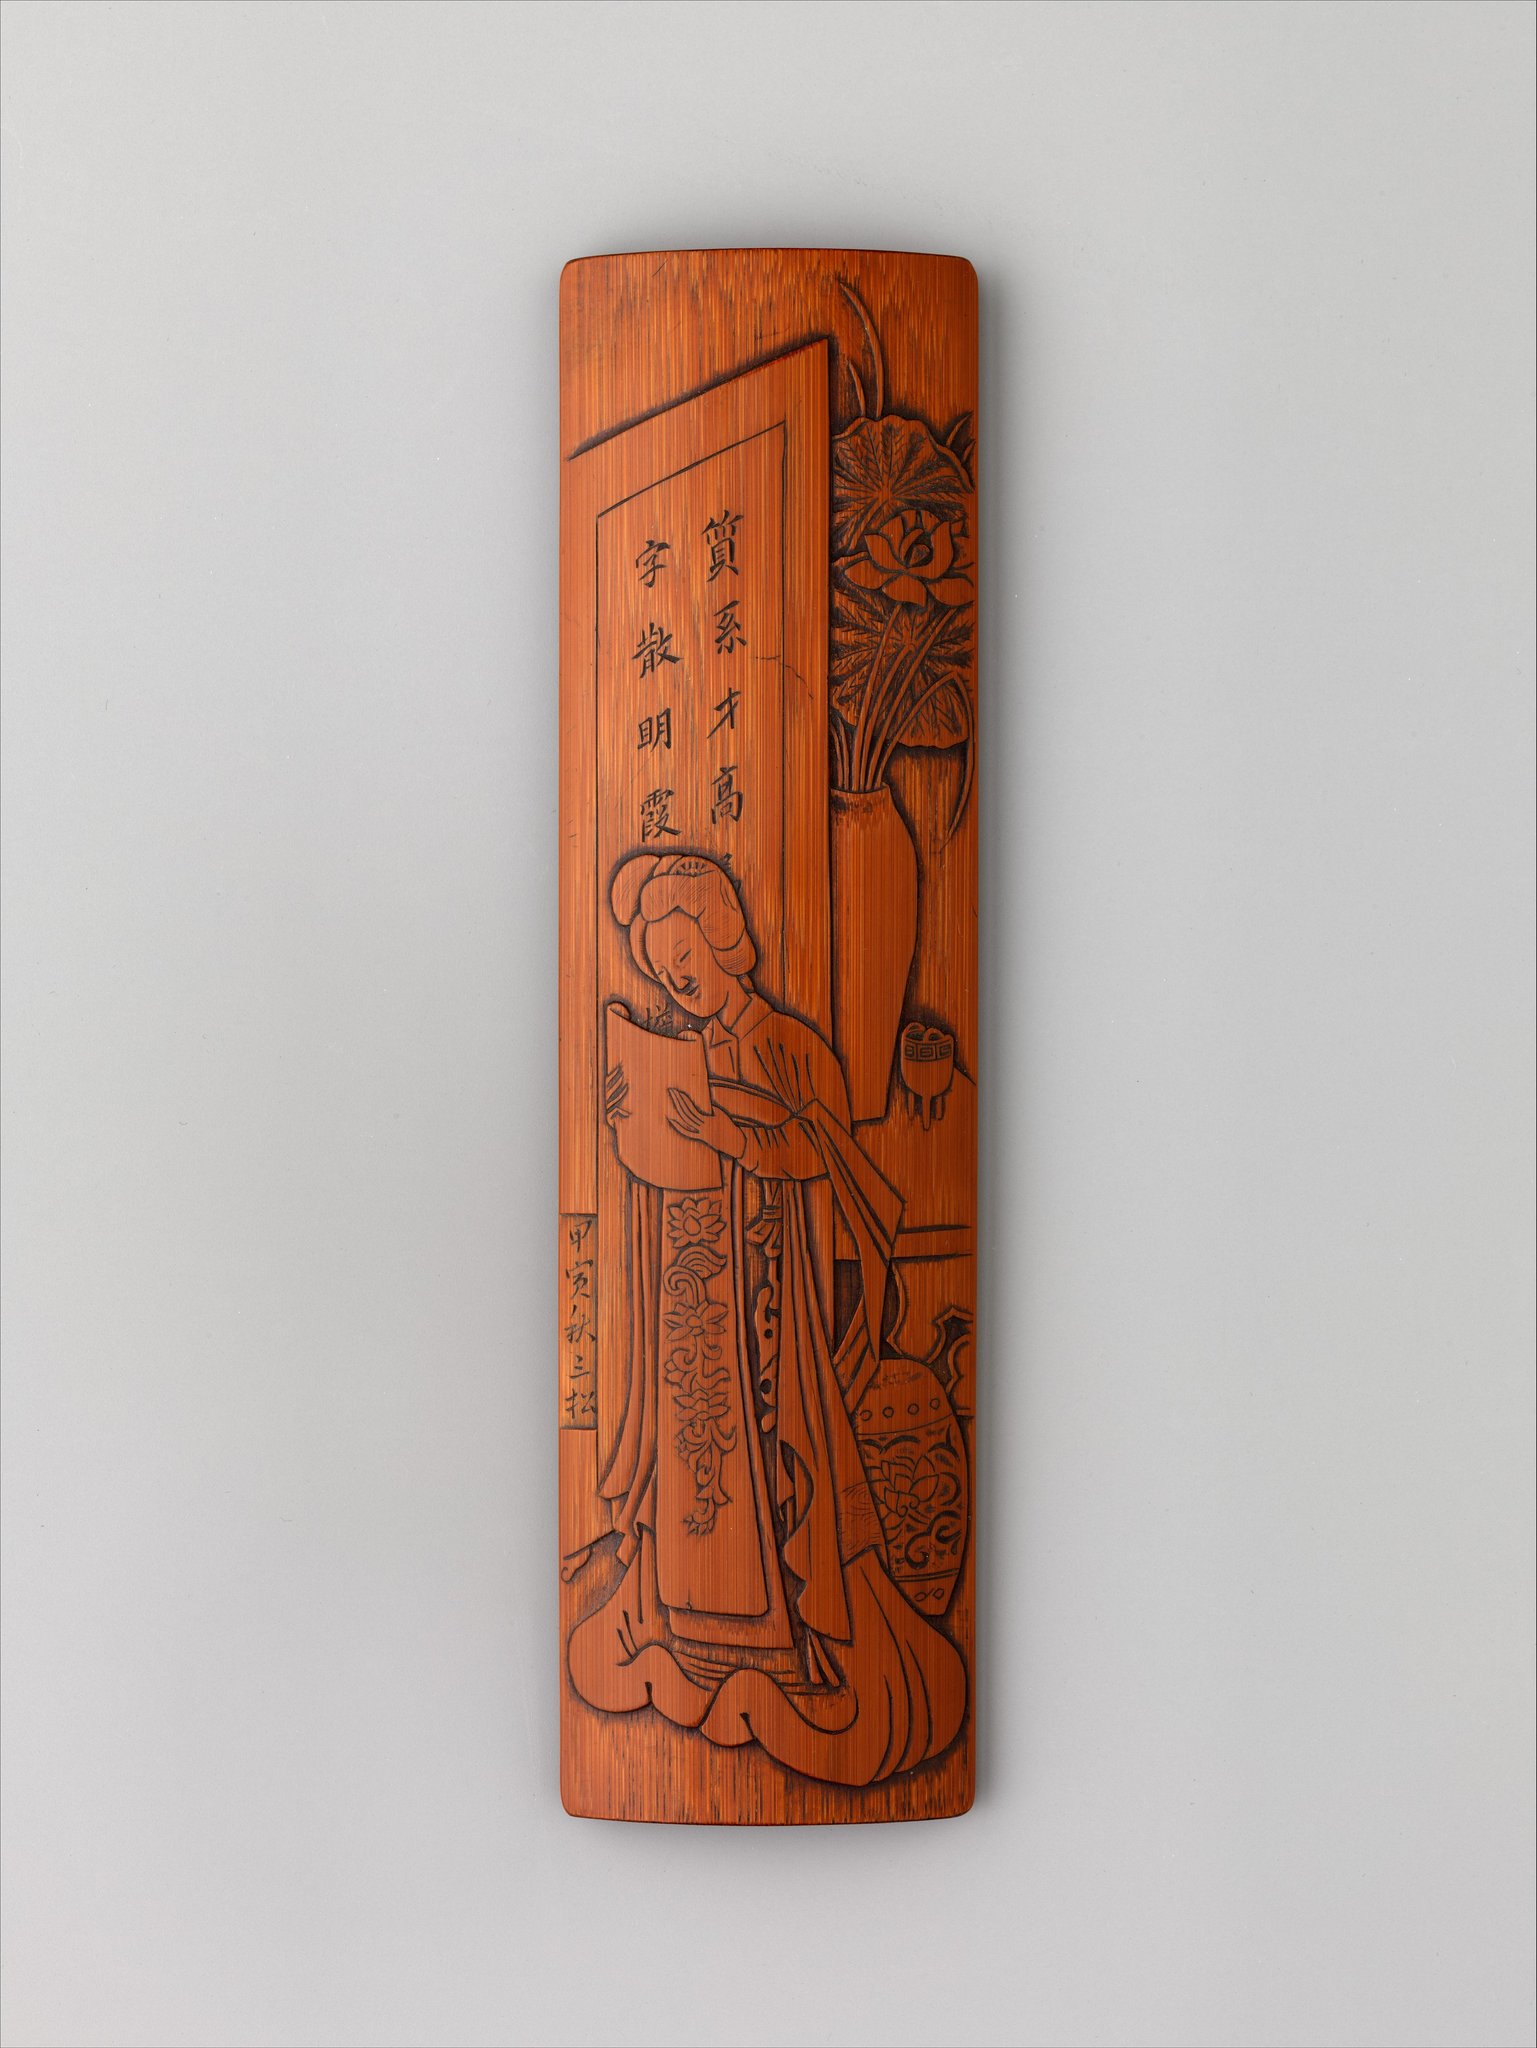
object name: wrist rest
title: Wrist Rest with Scene from "The West Chamber"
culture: chinese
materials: bamboo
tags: women,reading